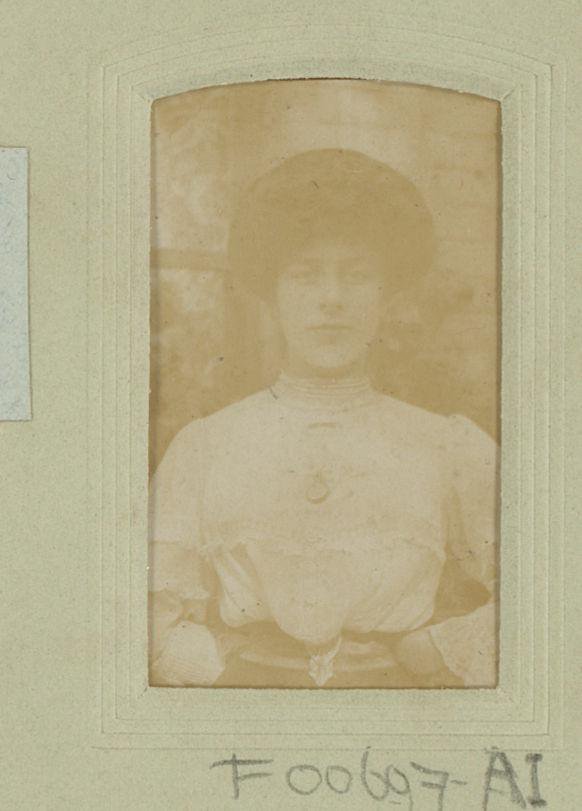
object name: photograph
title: Portret van een vrouw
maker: Anonymous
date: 1890-1915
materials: photographic support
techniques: daylight paper print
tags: adult woman, historical persons